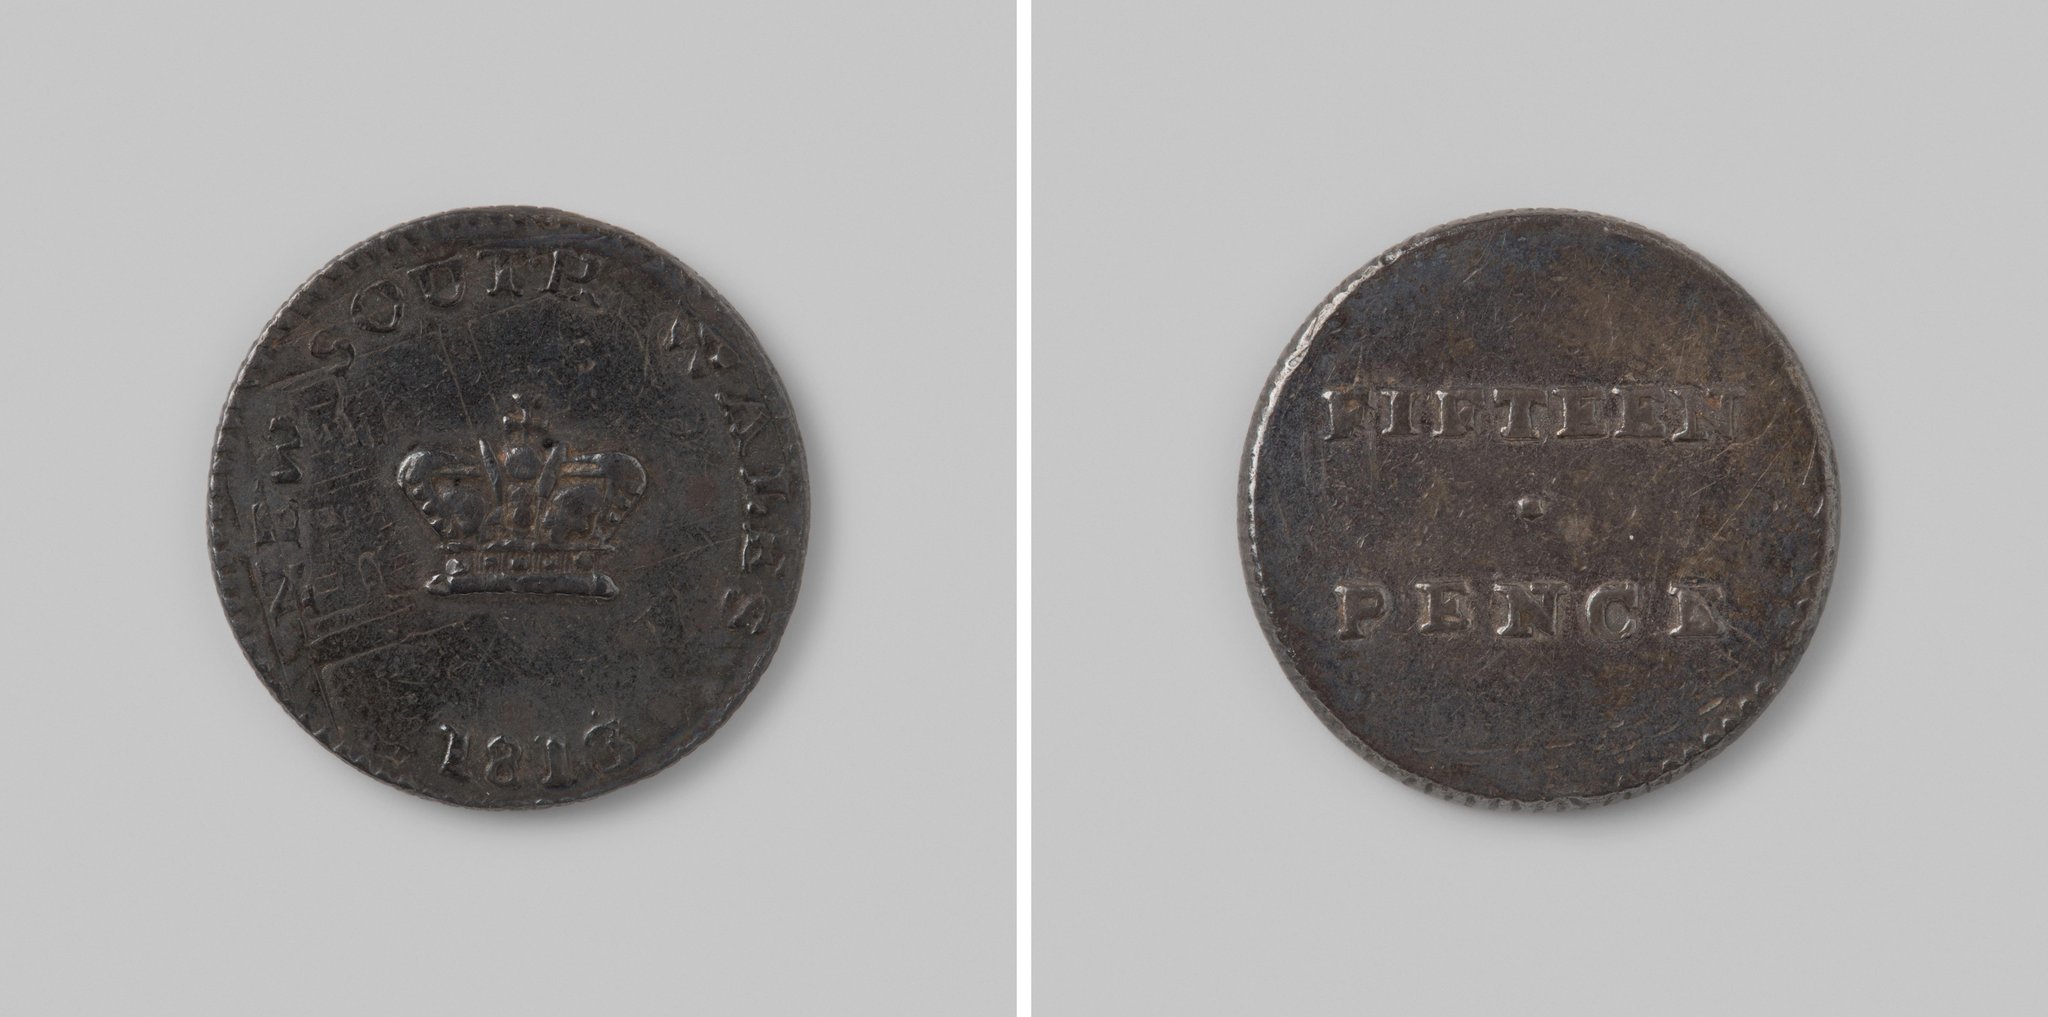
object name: coin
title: Vijftien pence uit Nieuw-Zuid-Wales, 1813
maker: william henshall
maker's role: die cutter, instrument maker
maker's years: 1770-1813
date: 1813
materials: silver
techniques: striking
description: Zilveren munt. Voorzijde: kroon, waaromheen als omschrift lands-aanduiding met onderaan jaartal. Keerzijde: in twee regels waarde-aanduiding. Kabelrand. Munt is geslagen op middenstuk van een peso of 8 realen. Op de voorzijde is een gedeelte van het Spaanse wapenschild nog vaag zichtbaar.